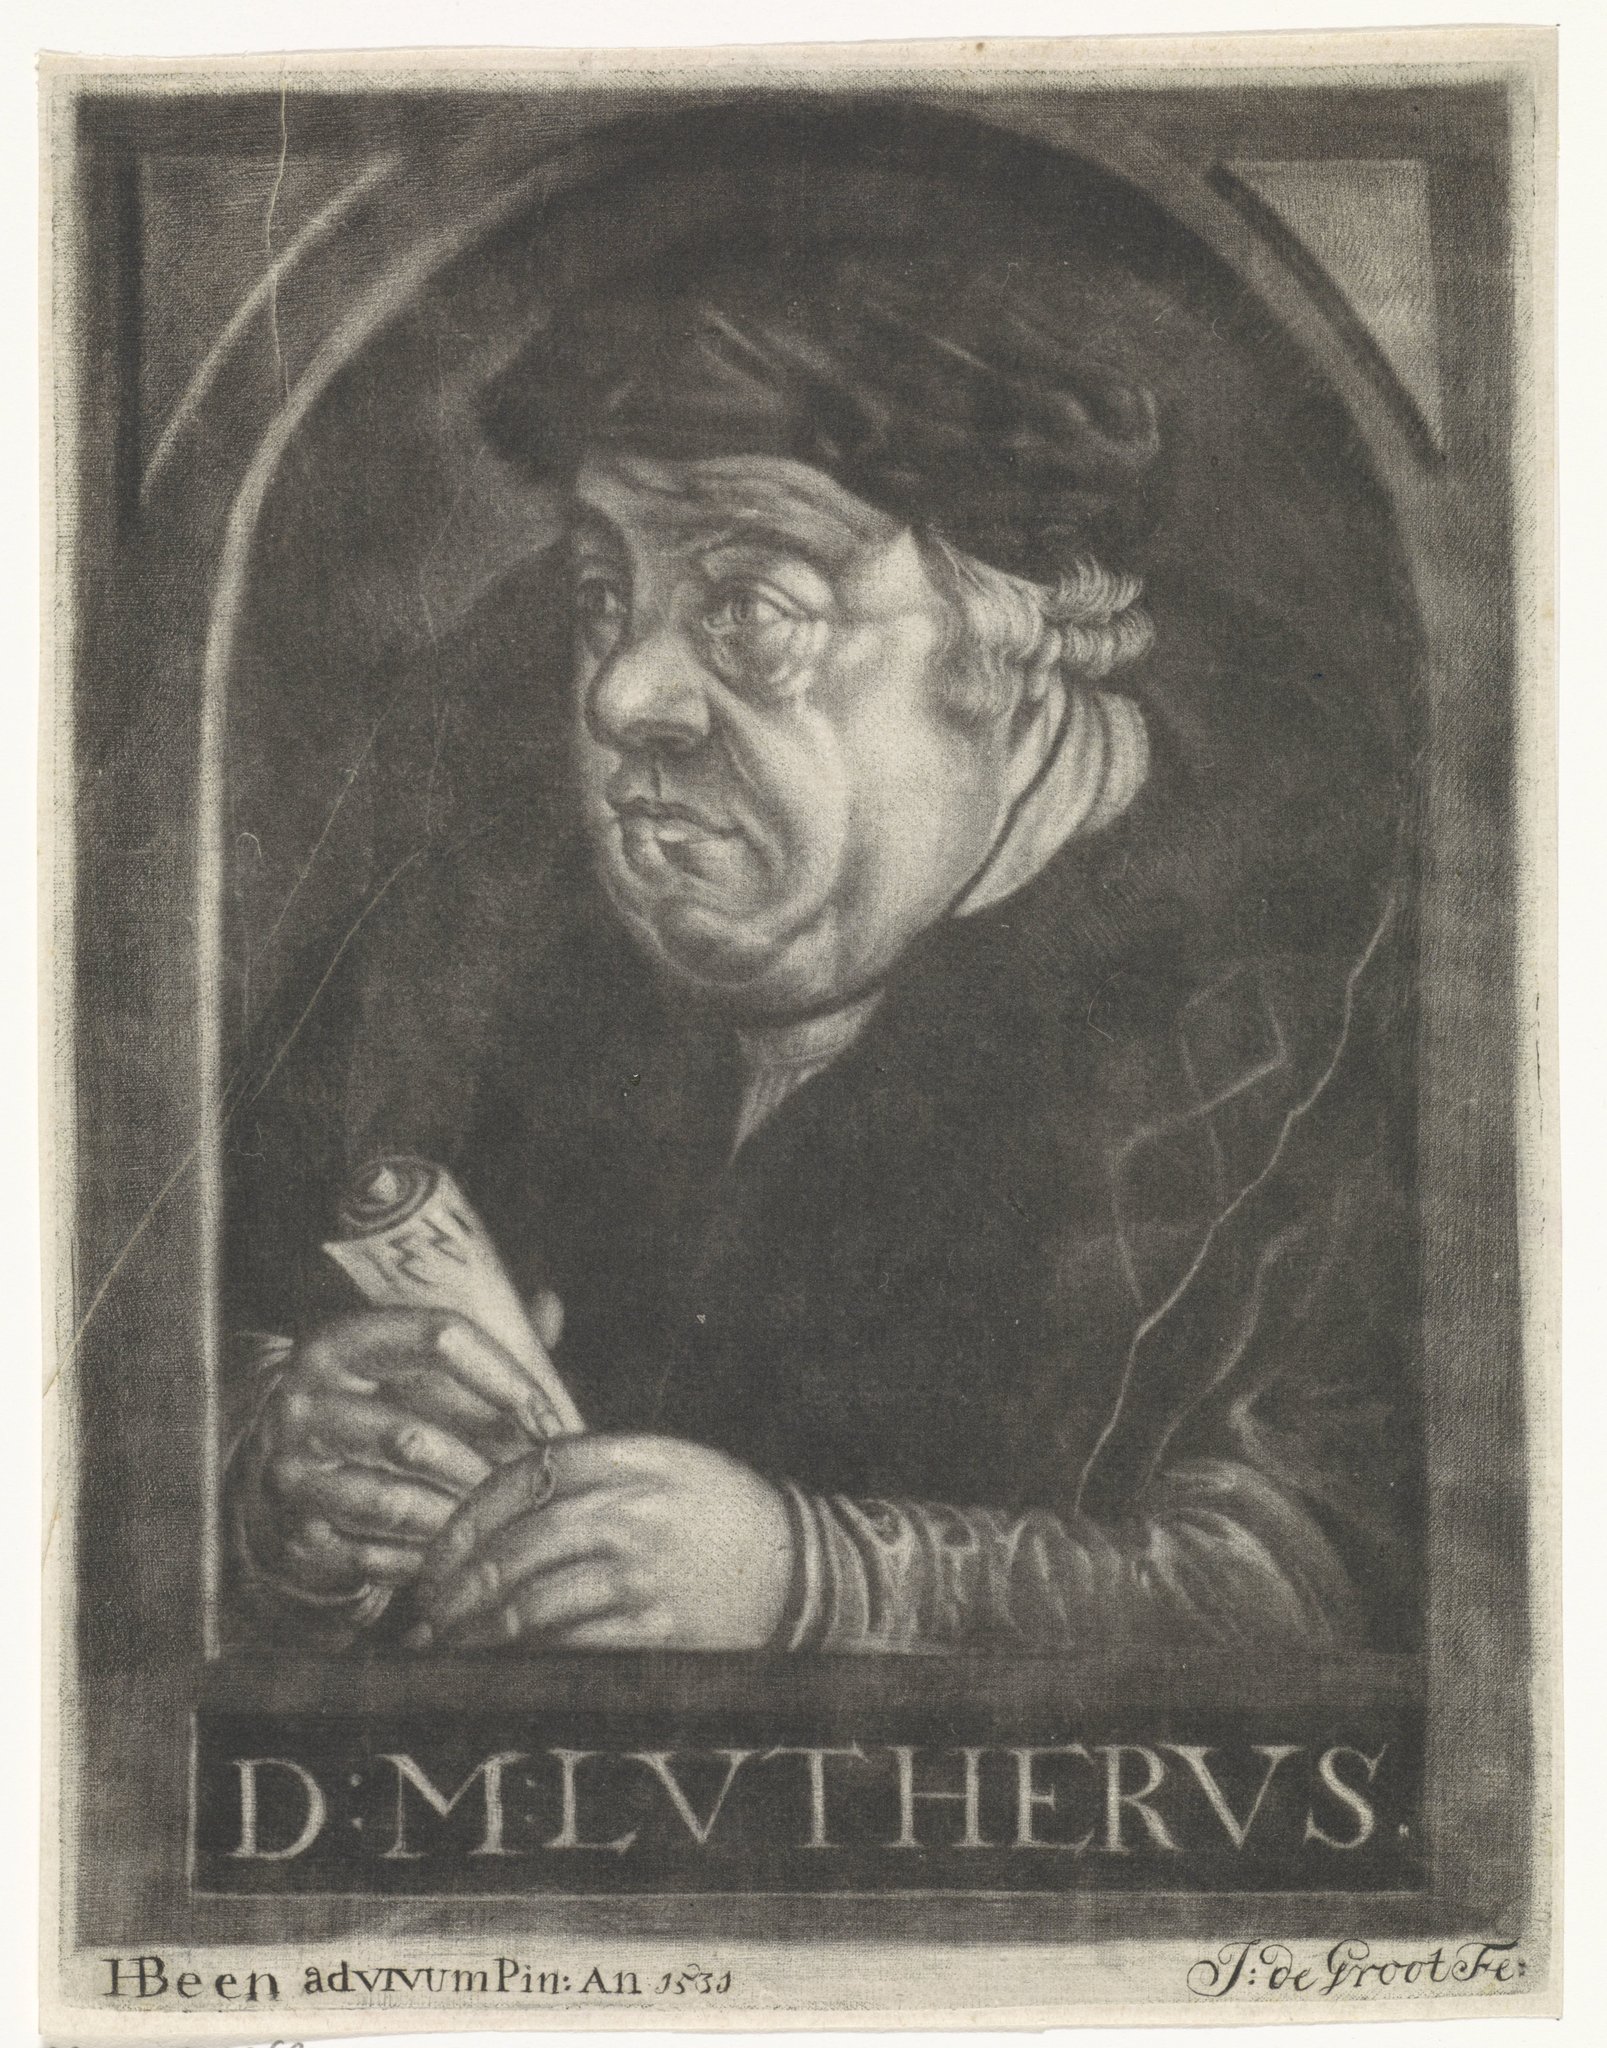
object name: print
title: Portret van Martin Luther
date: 1722-1745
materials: paper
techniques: engraving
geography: northern netherlands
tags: martin luther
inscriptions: collector's mark: Lugt 2228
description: De theoloog Martin Luther met in zijn hand een rol papier. Hij draagt een toga.